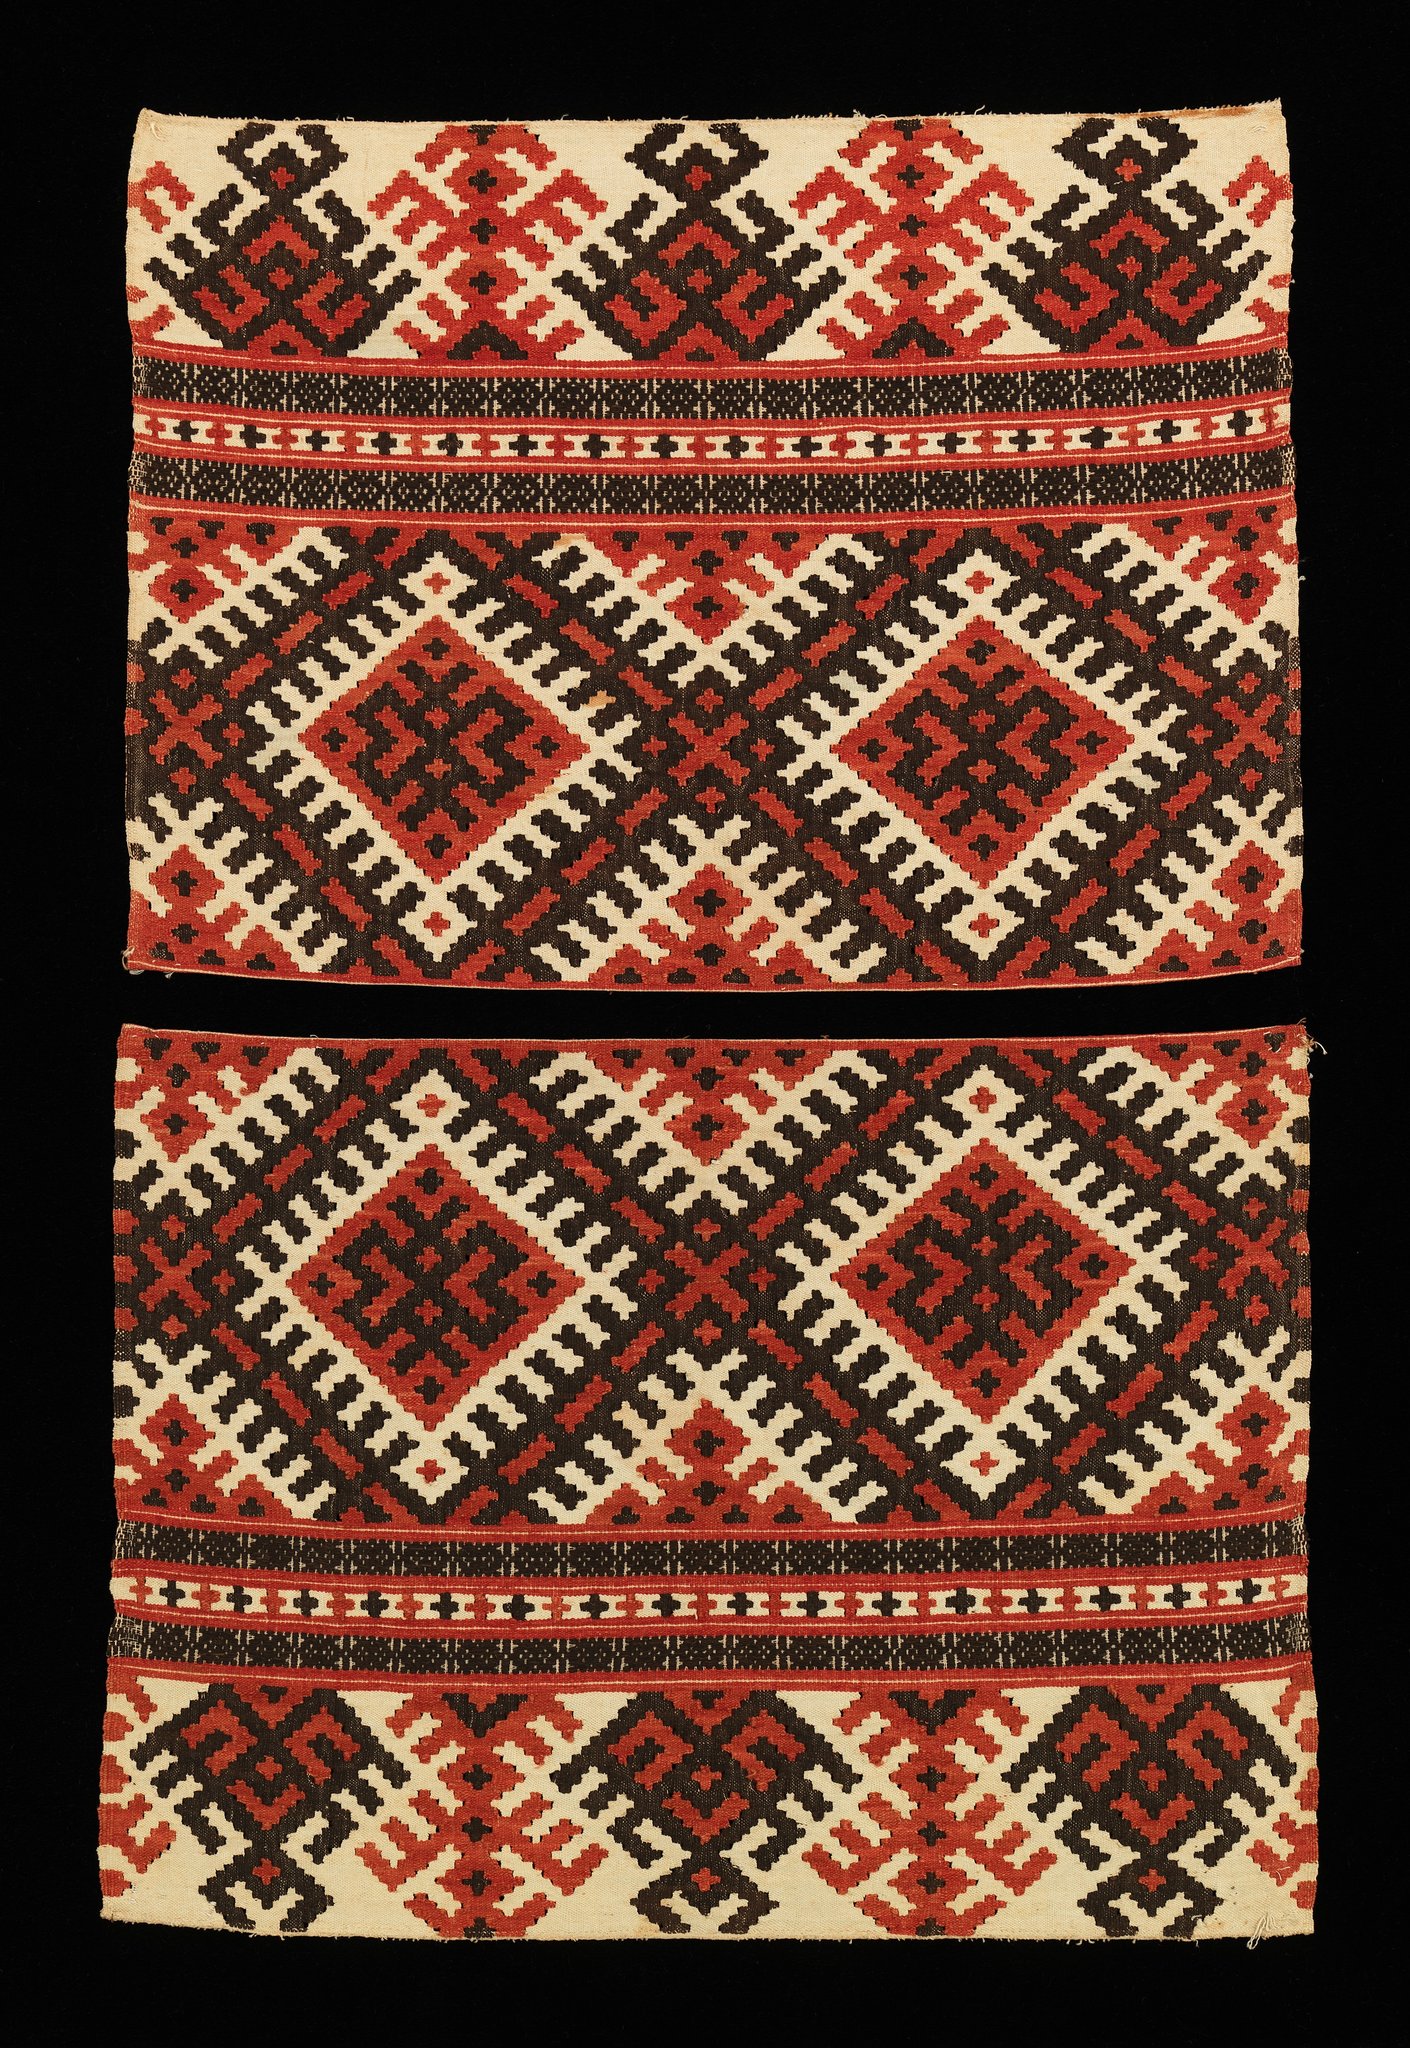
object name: textile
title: Towel border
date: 1840-1870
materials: linen